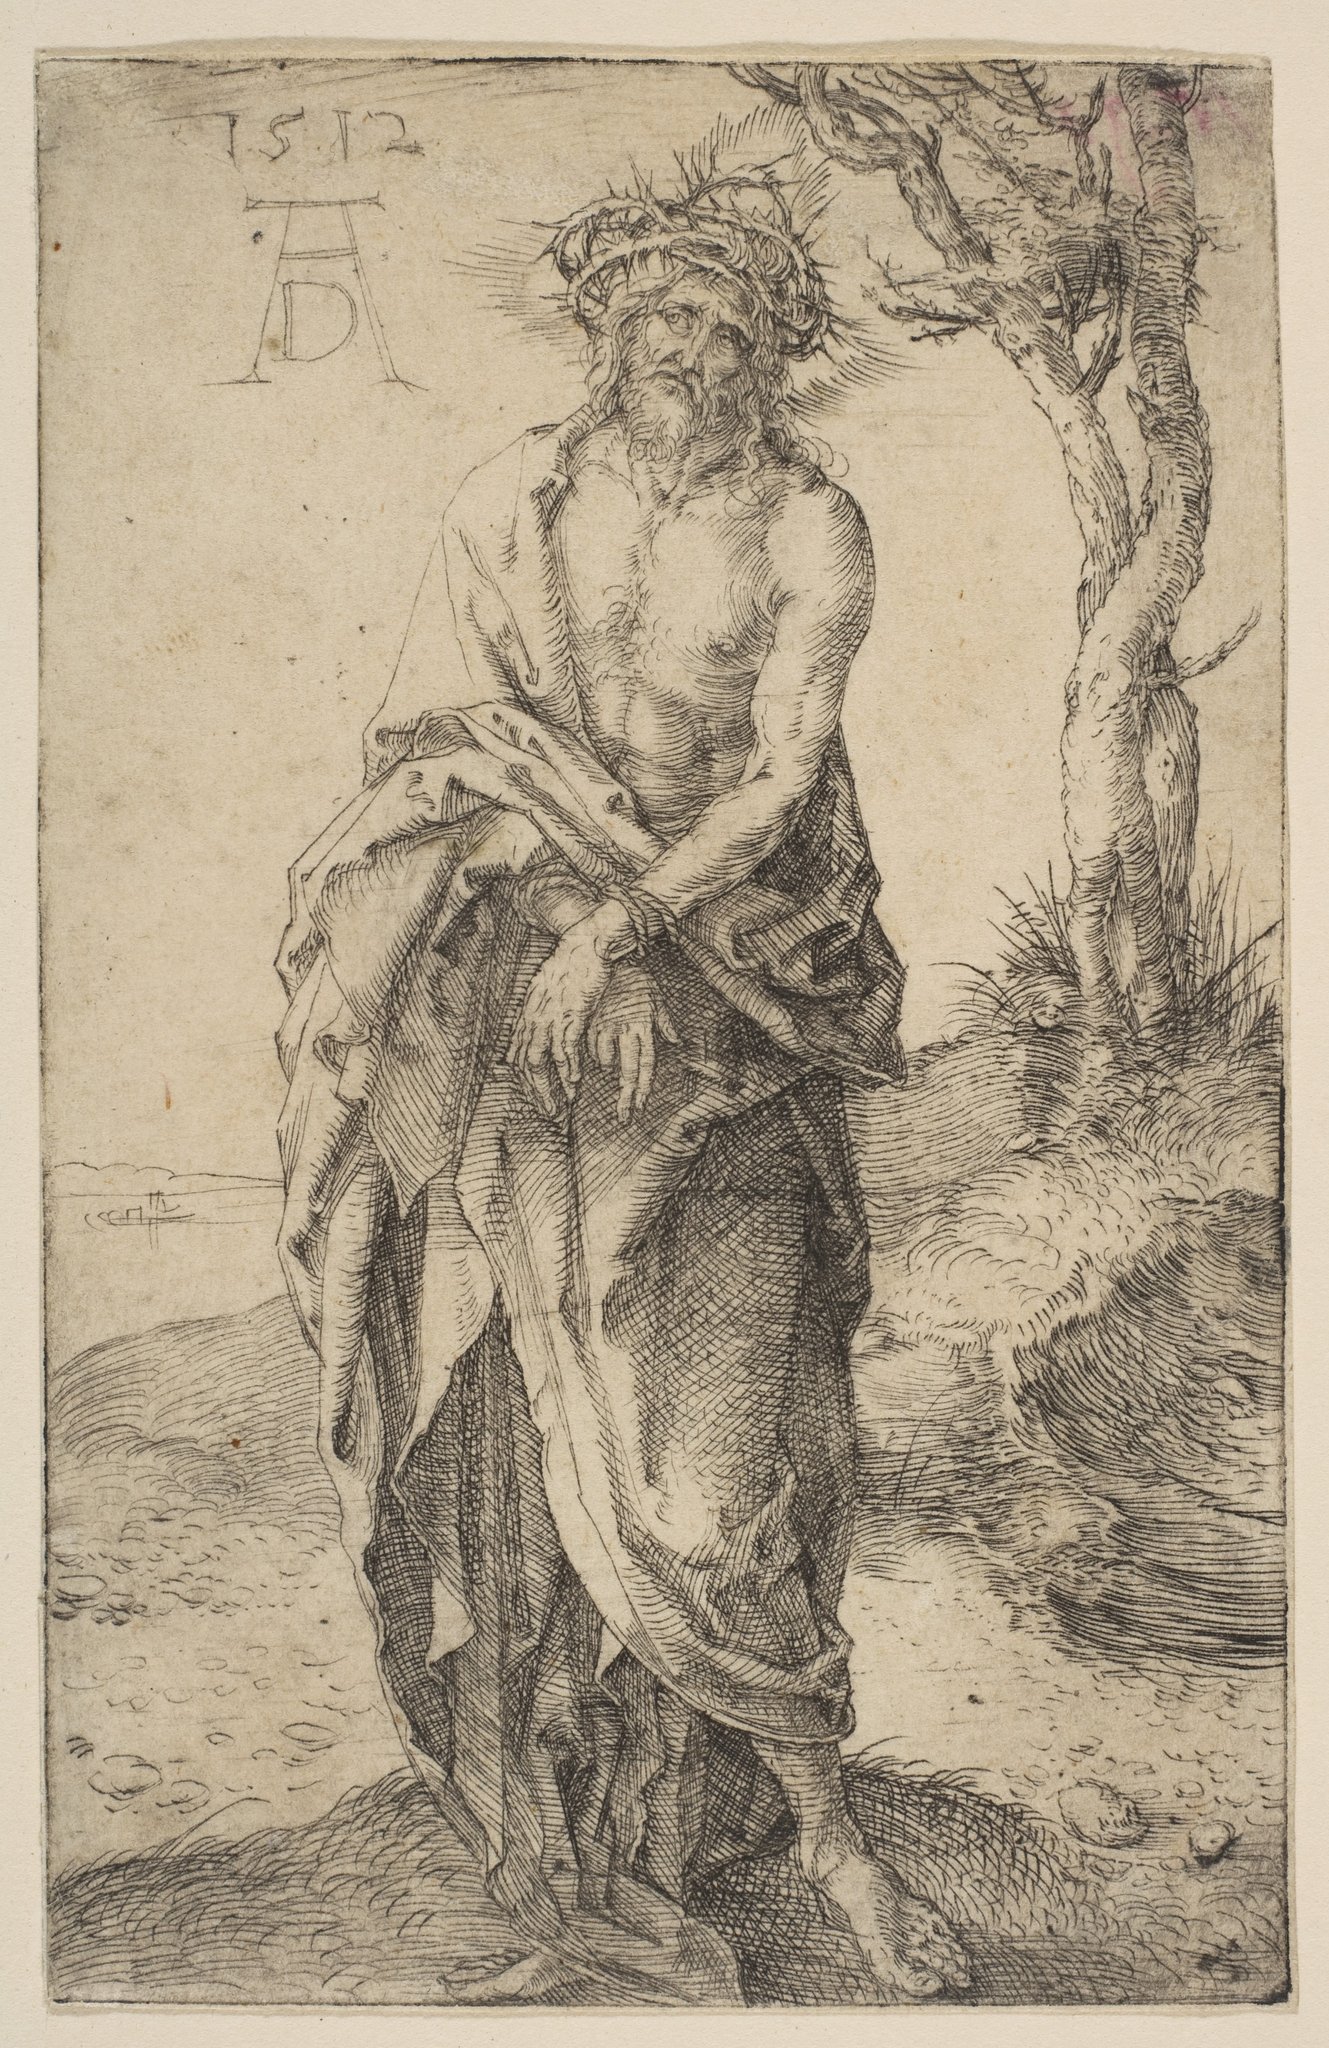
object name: print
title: Man of Sorrows with Hands Bound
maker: albrecht dürer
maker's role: artist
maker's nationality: german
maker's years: 1471-1528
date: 1512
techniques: drypoint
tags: sadness,christ